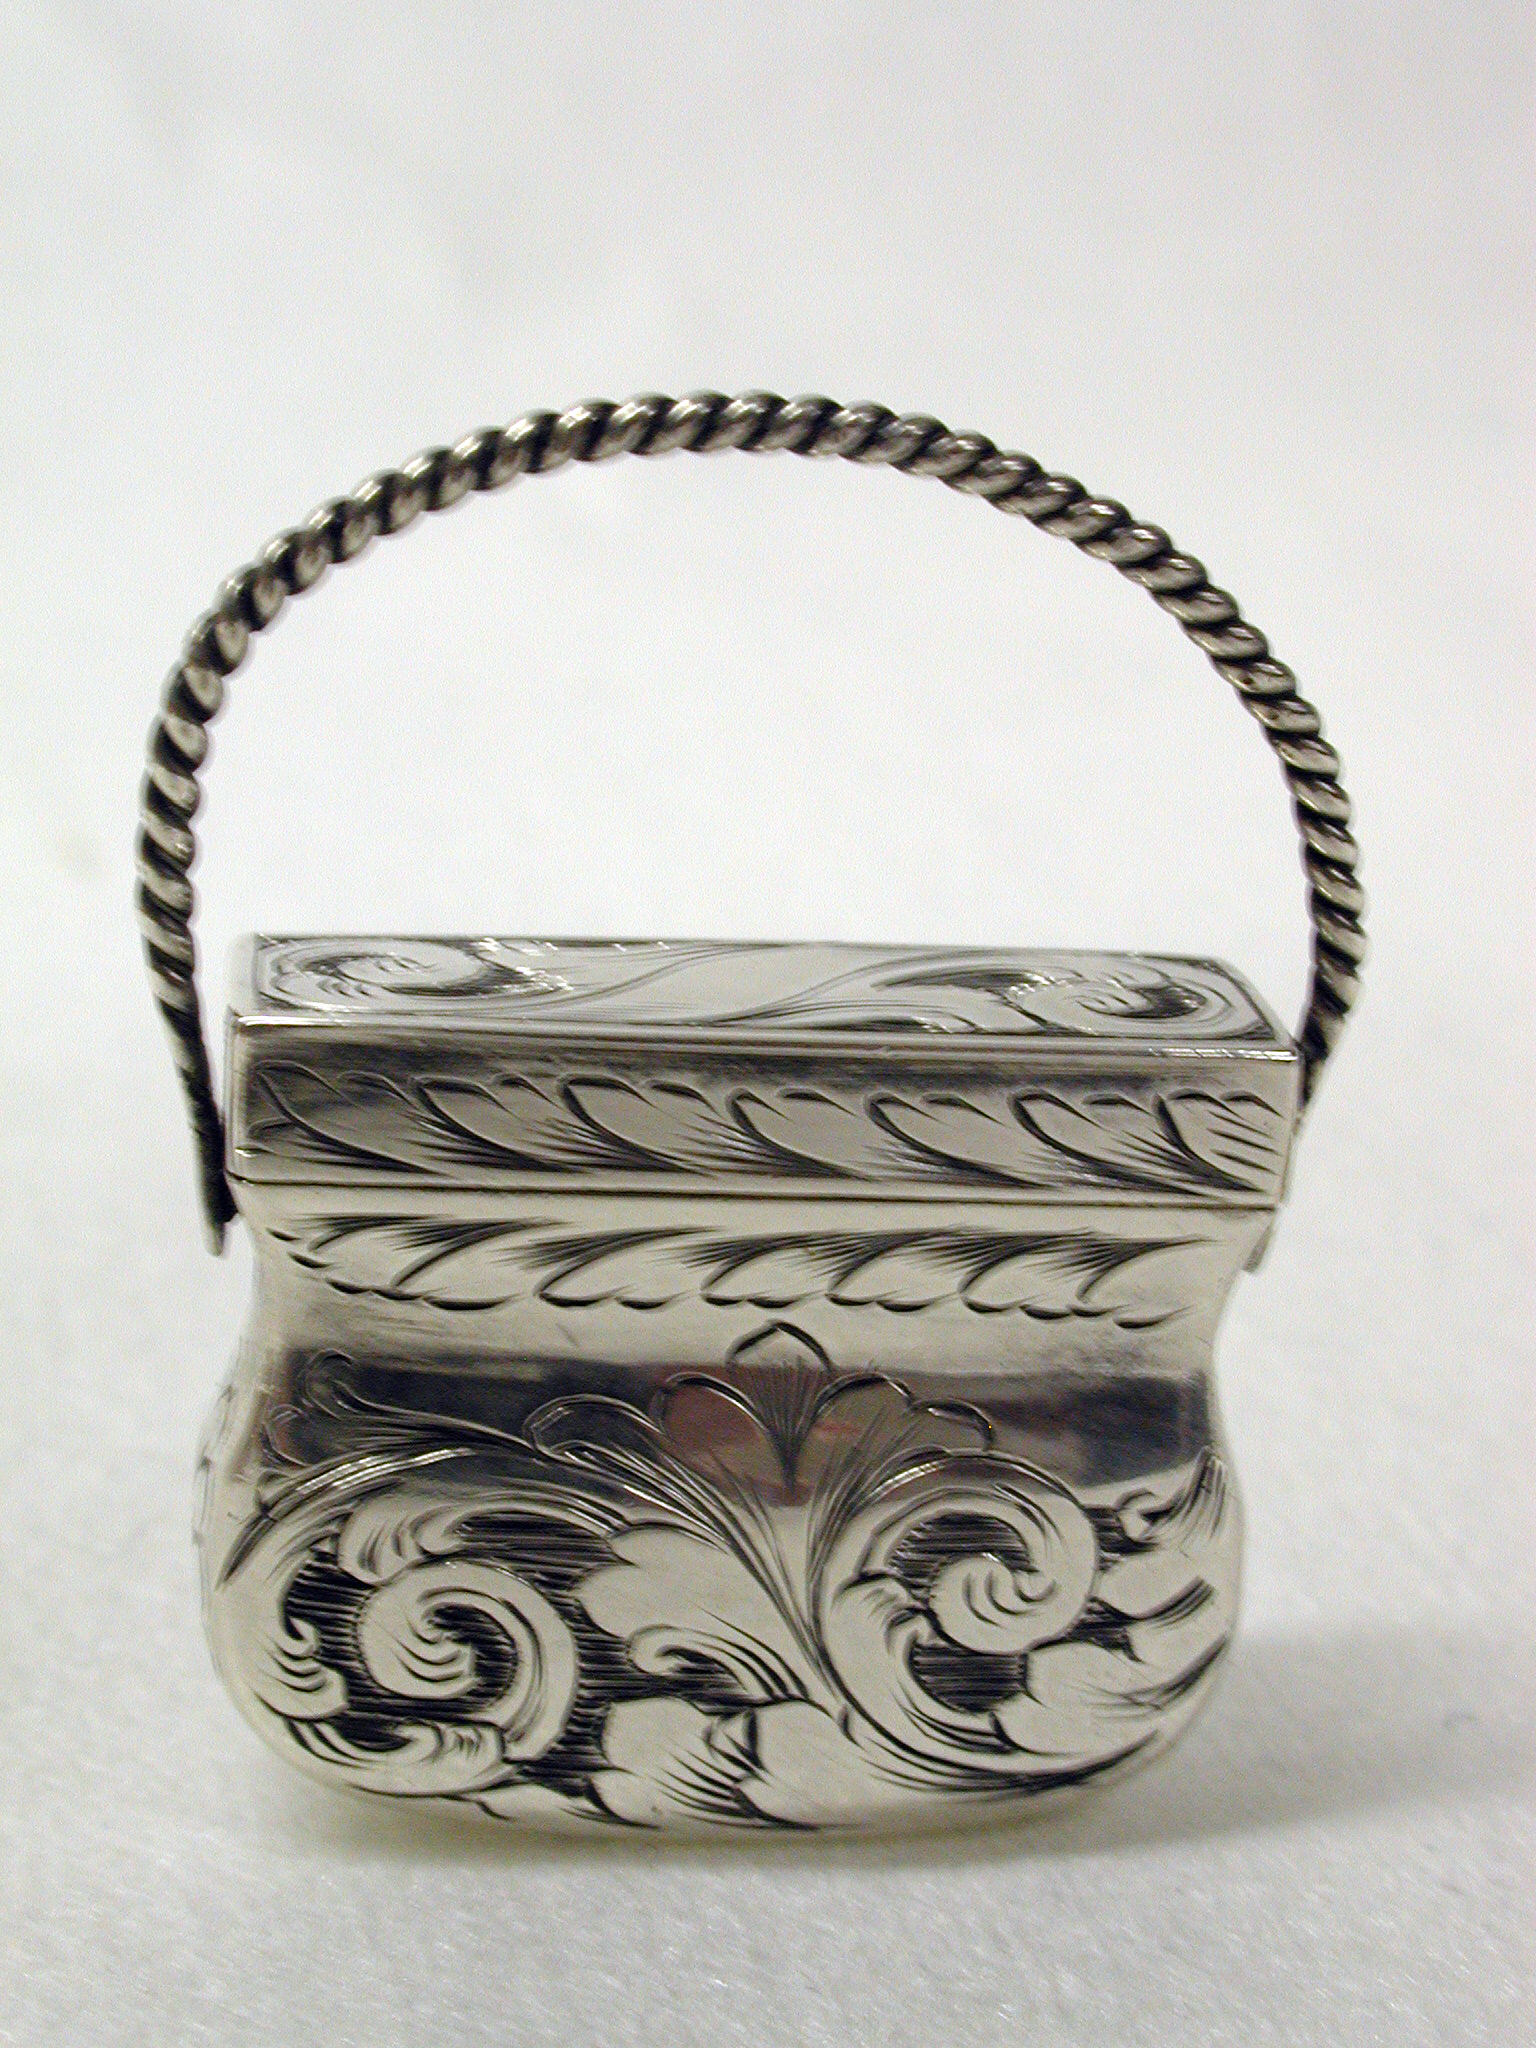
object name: vinaigrette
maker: gervase wheeler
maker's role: maker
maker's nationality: british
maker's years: 1831-1875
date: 1835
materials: silver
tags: flowers